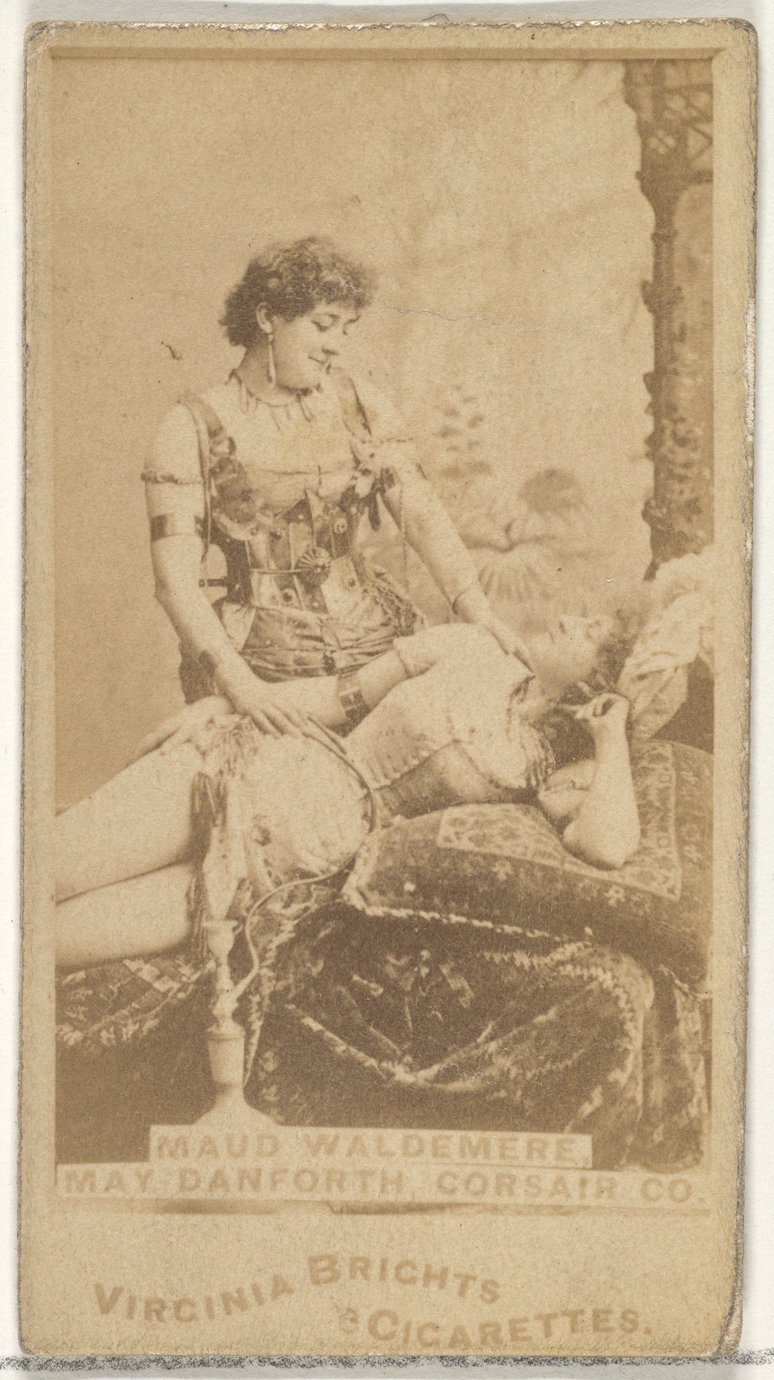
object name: photograph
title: Maud Waldemere and May Danforth, Corsair Co., from the Actors and Actresses series (N45, Type 1) for Virginia Brights Cigarettes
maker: allen & ginter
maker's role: publisher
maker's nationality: american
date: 1888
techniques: albumen silver print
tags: women,actresses